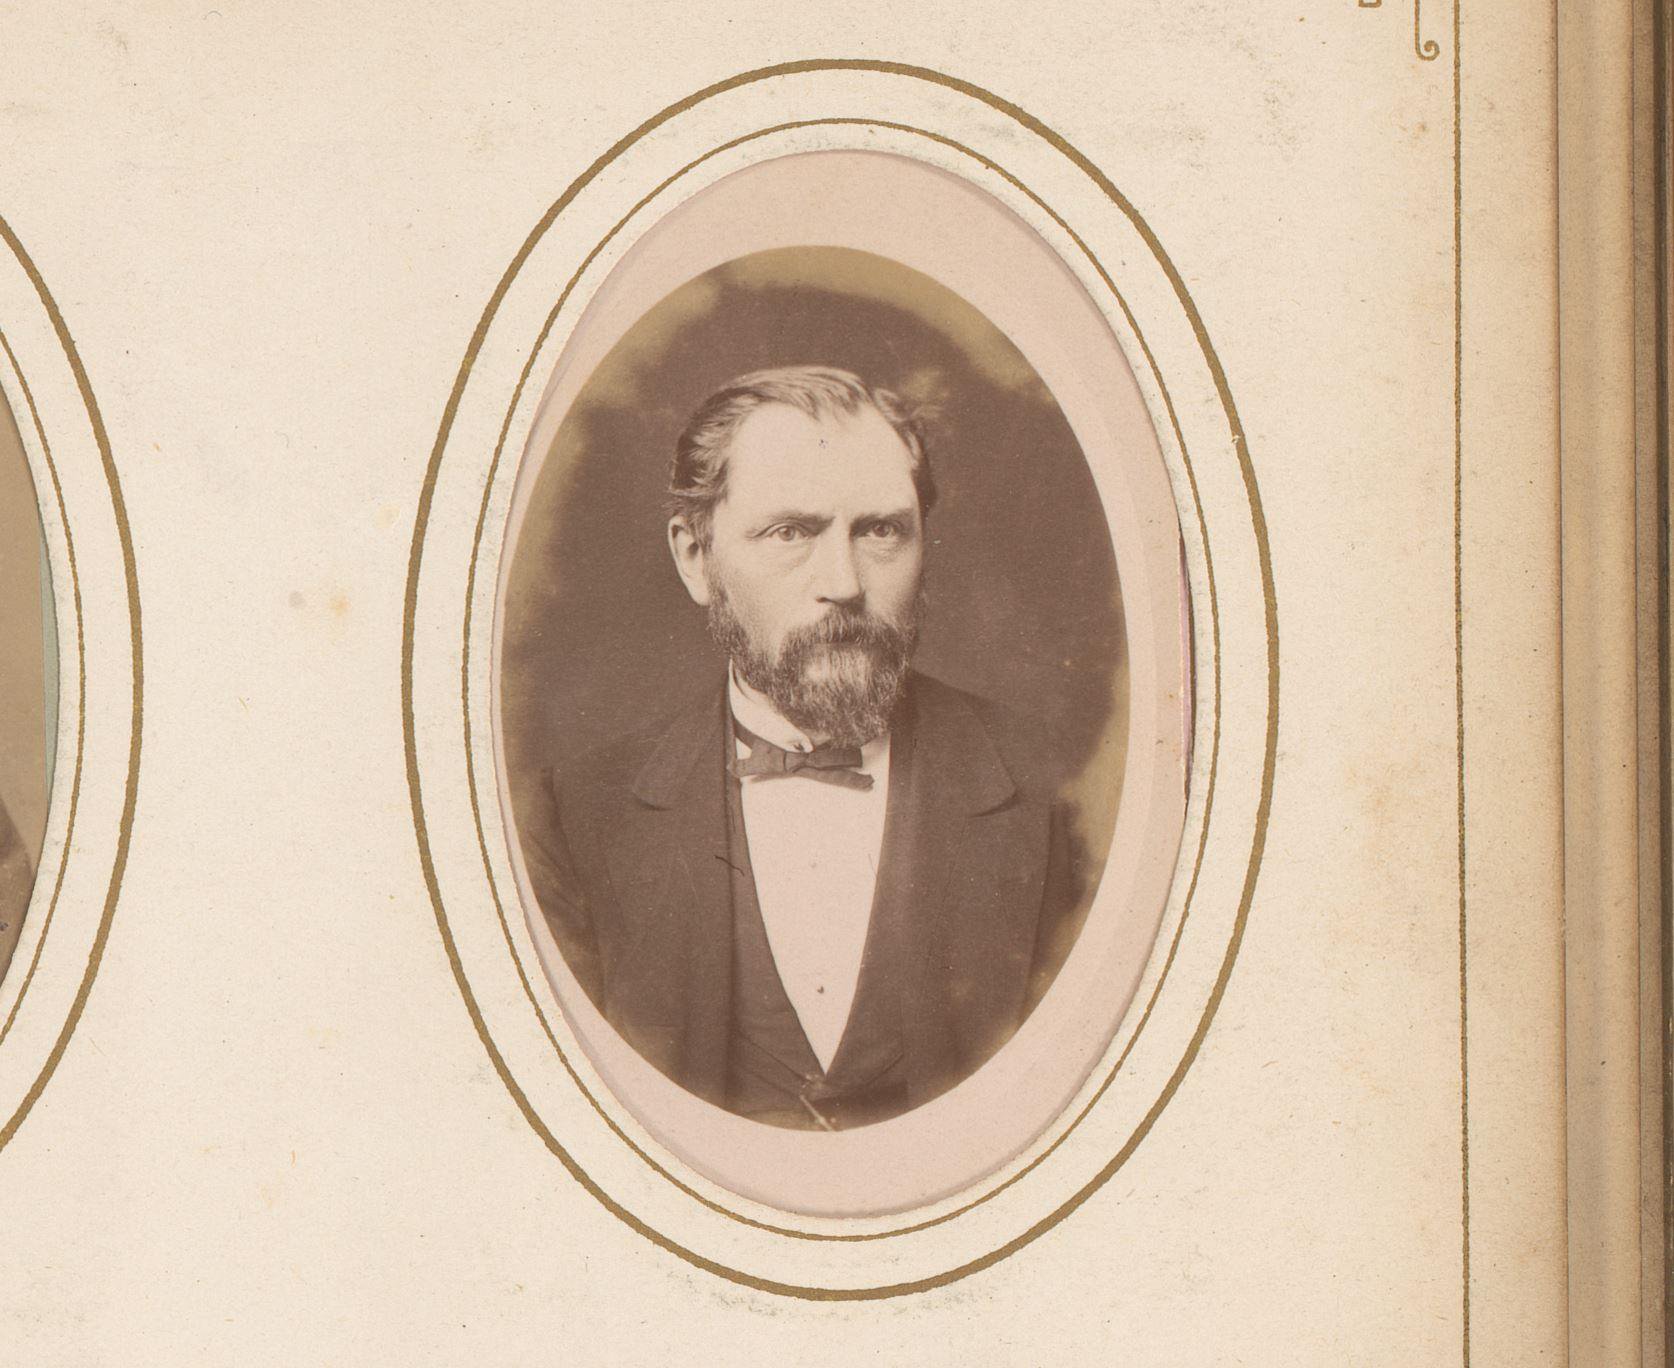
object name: semi enamel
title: Portret van een man met snor en baard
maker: jean leplat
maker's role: fotograaf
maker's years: 1847-1928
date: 1878-1889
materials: cardboard, celluloid, photographic support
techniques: albumen print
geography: elsene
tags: moustache, historical persons, beard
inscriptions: inscription: ‘Photographie Artistique/ et Inaltérable./ J. Leplat/ 4, Rue de Berlin, 4/ (CHAUSSÉE de WAVRE)/ Bruxelles-Ixelles/ ATELIER DE POSE AU REZ-DE-CHAUSSÉE/ Nota: Les Clichés sont conservés.’